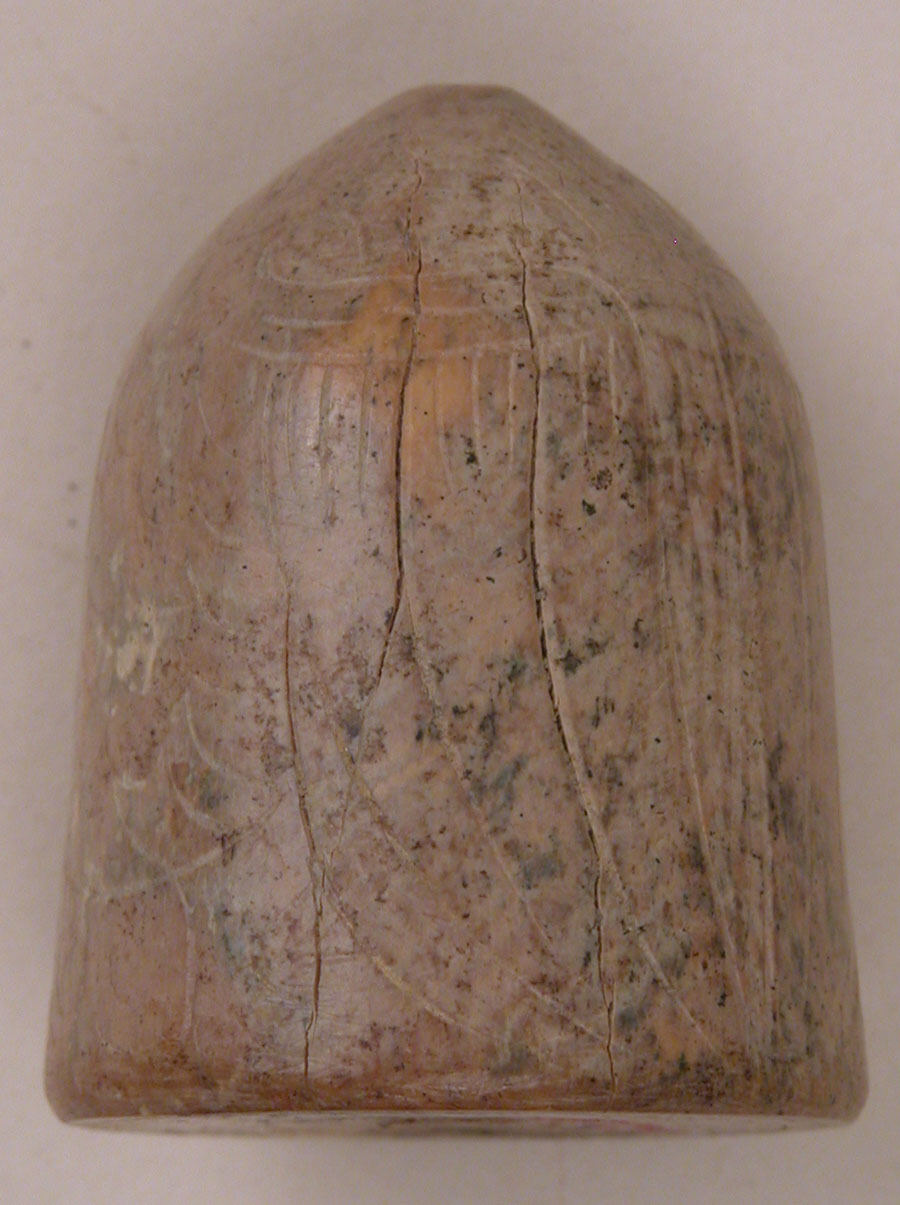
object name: chess or backgammon piece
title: Chess Piece, Pawn or Backgammon Piece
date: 1001-1200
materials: ivory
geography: western islamic lands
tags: chess,games